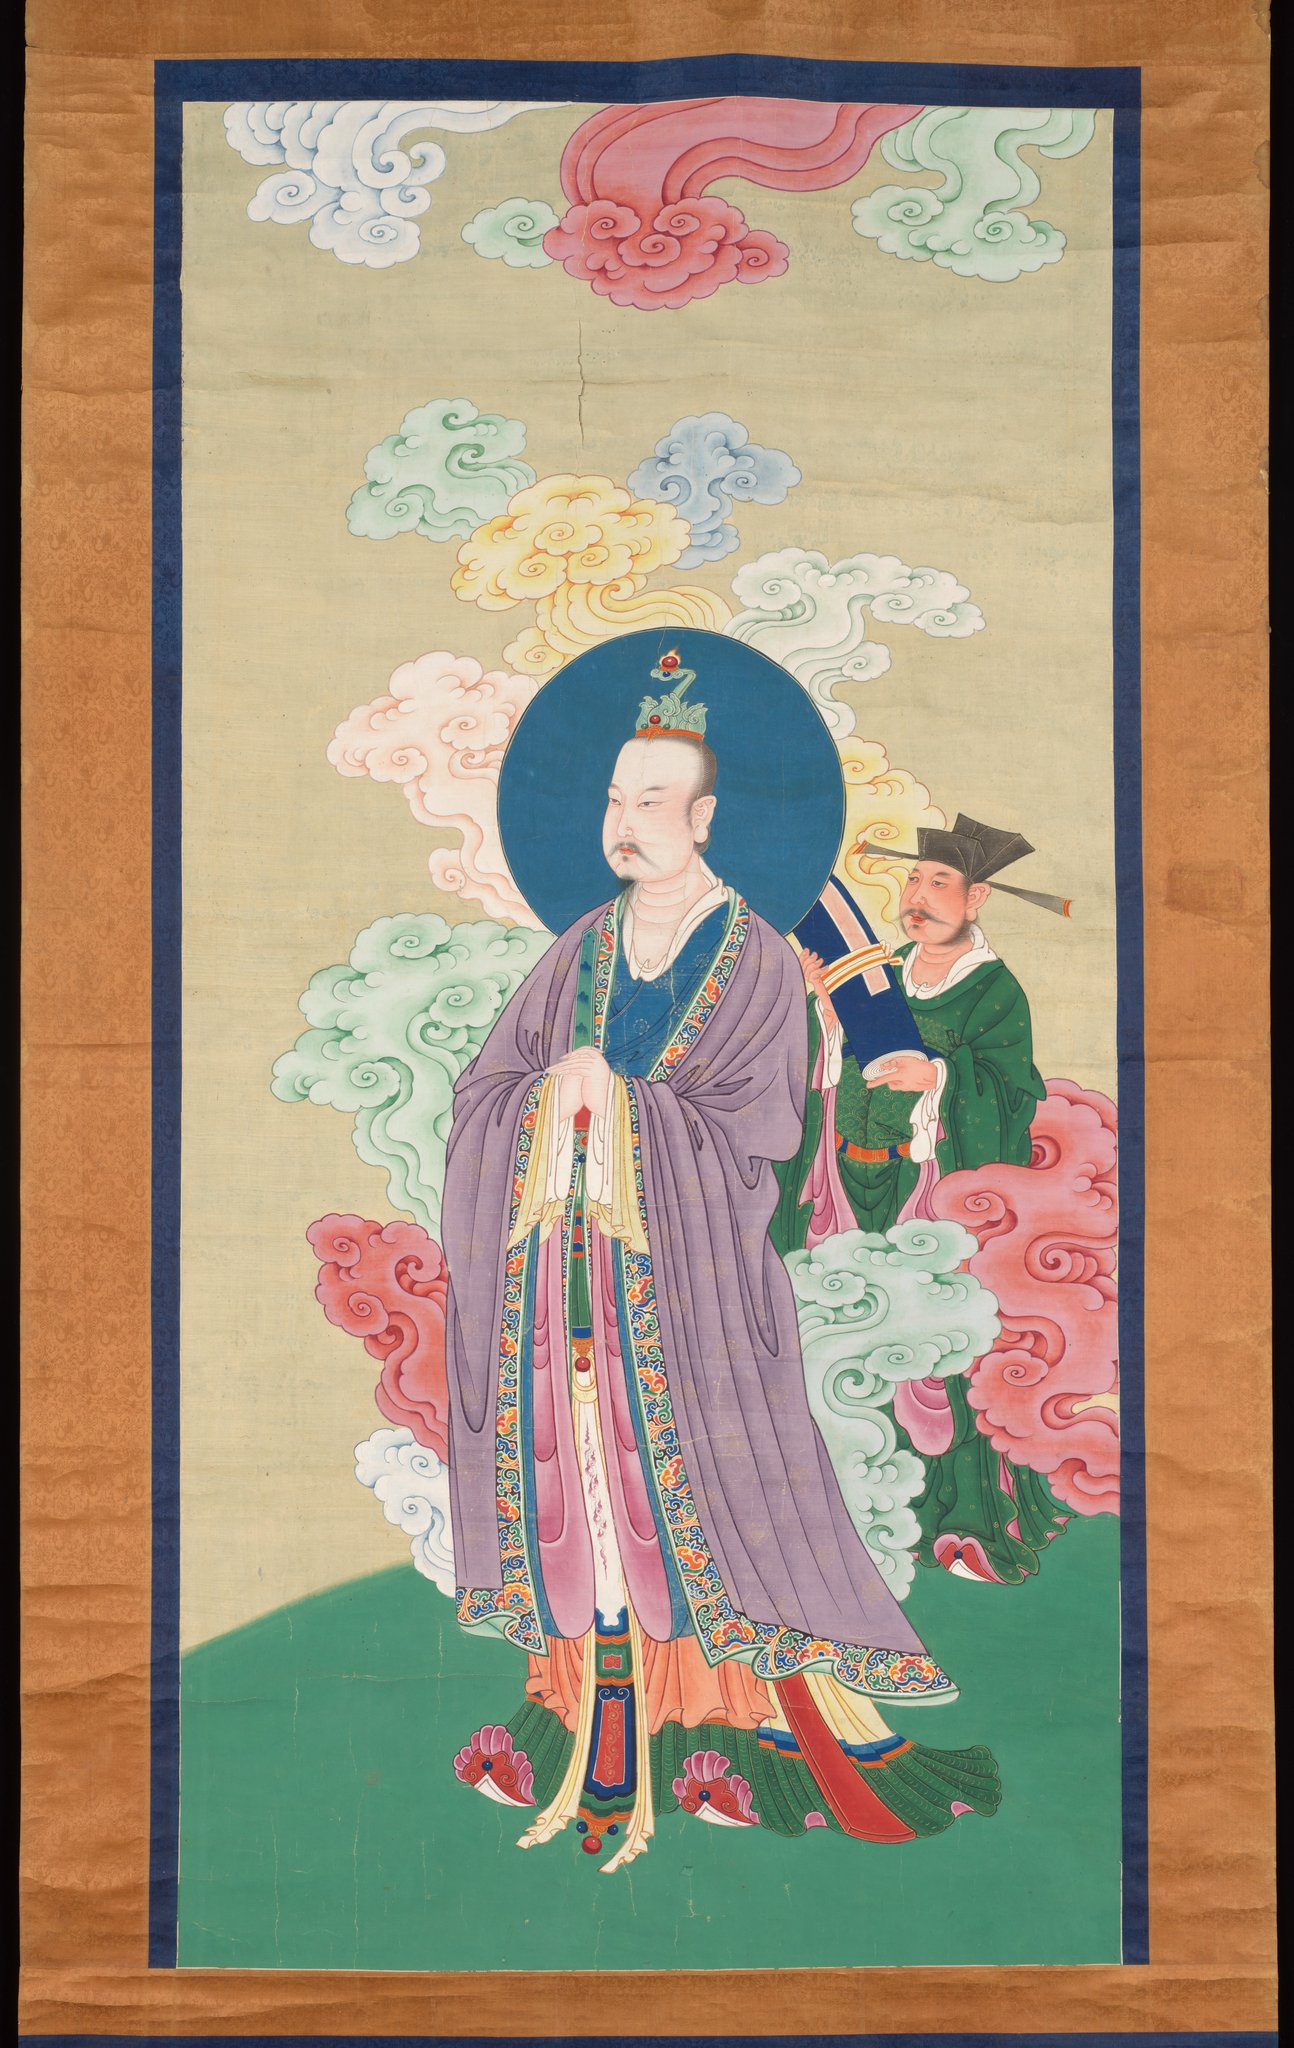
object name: hanging scroll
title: One of the Taoist Masters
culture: chinese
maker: unidentified artist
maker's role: artist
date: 1368-1911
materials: ink, paper